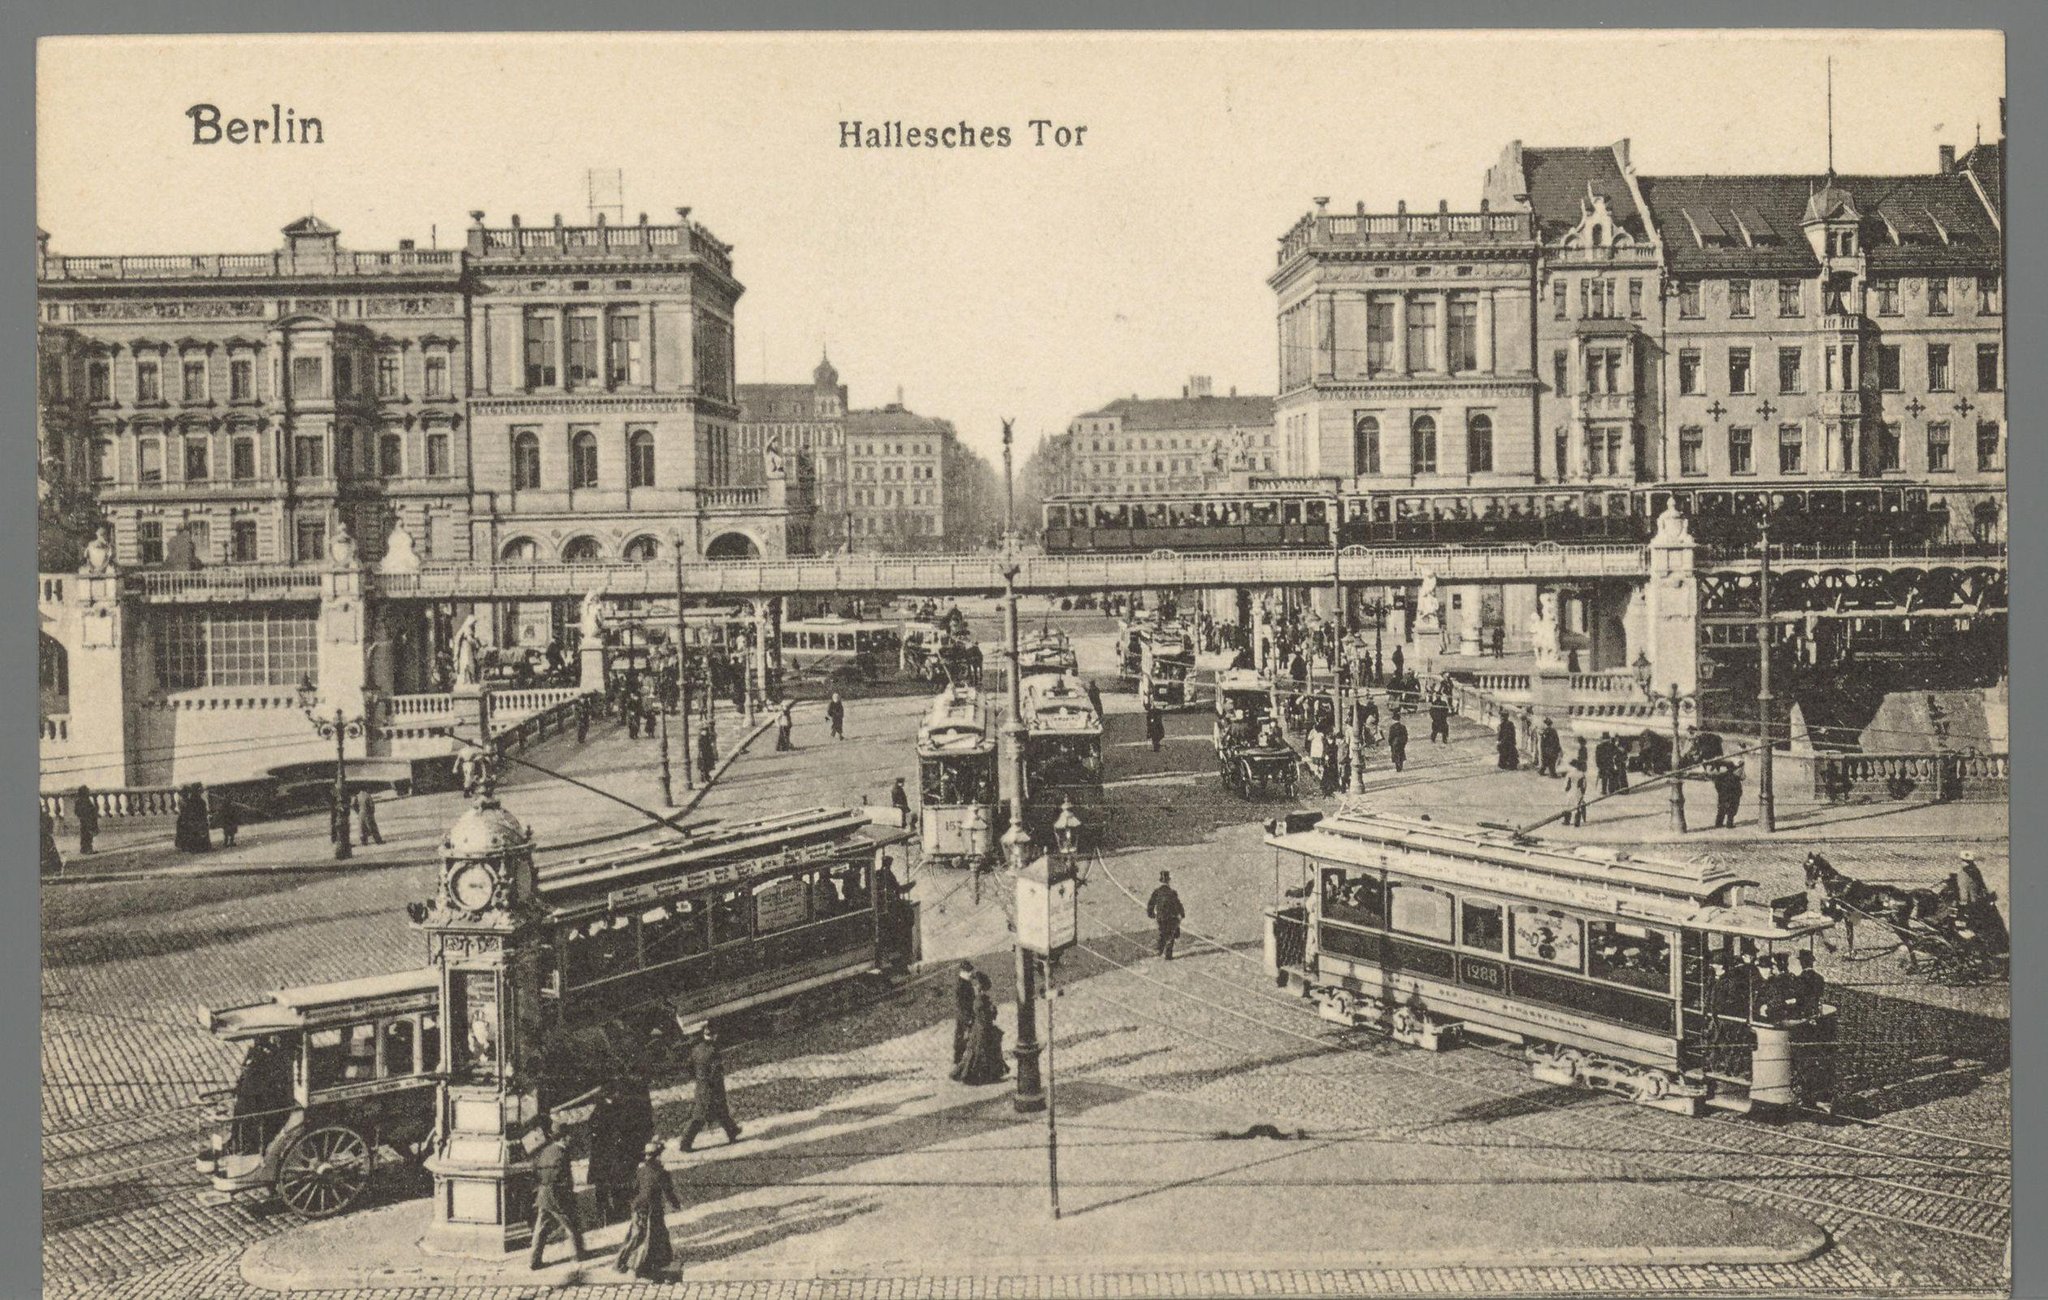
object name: ansichtkaart, prentbriefkaart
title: Berlin. Hallesches Tor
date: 1905-1930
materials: cardboard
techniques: photograph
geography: berlin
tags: railway, train, station; shelter (railway, tramway), street, berlin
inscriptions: stamp: ‘5’, monogram: ‘P.F.B.’